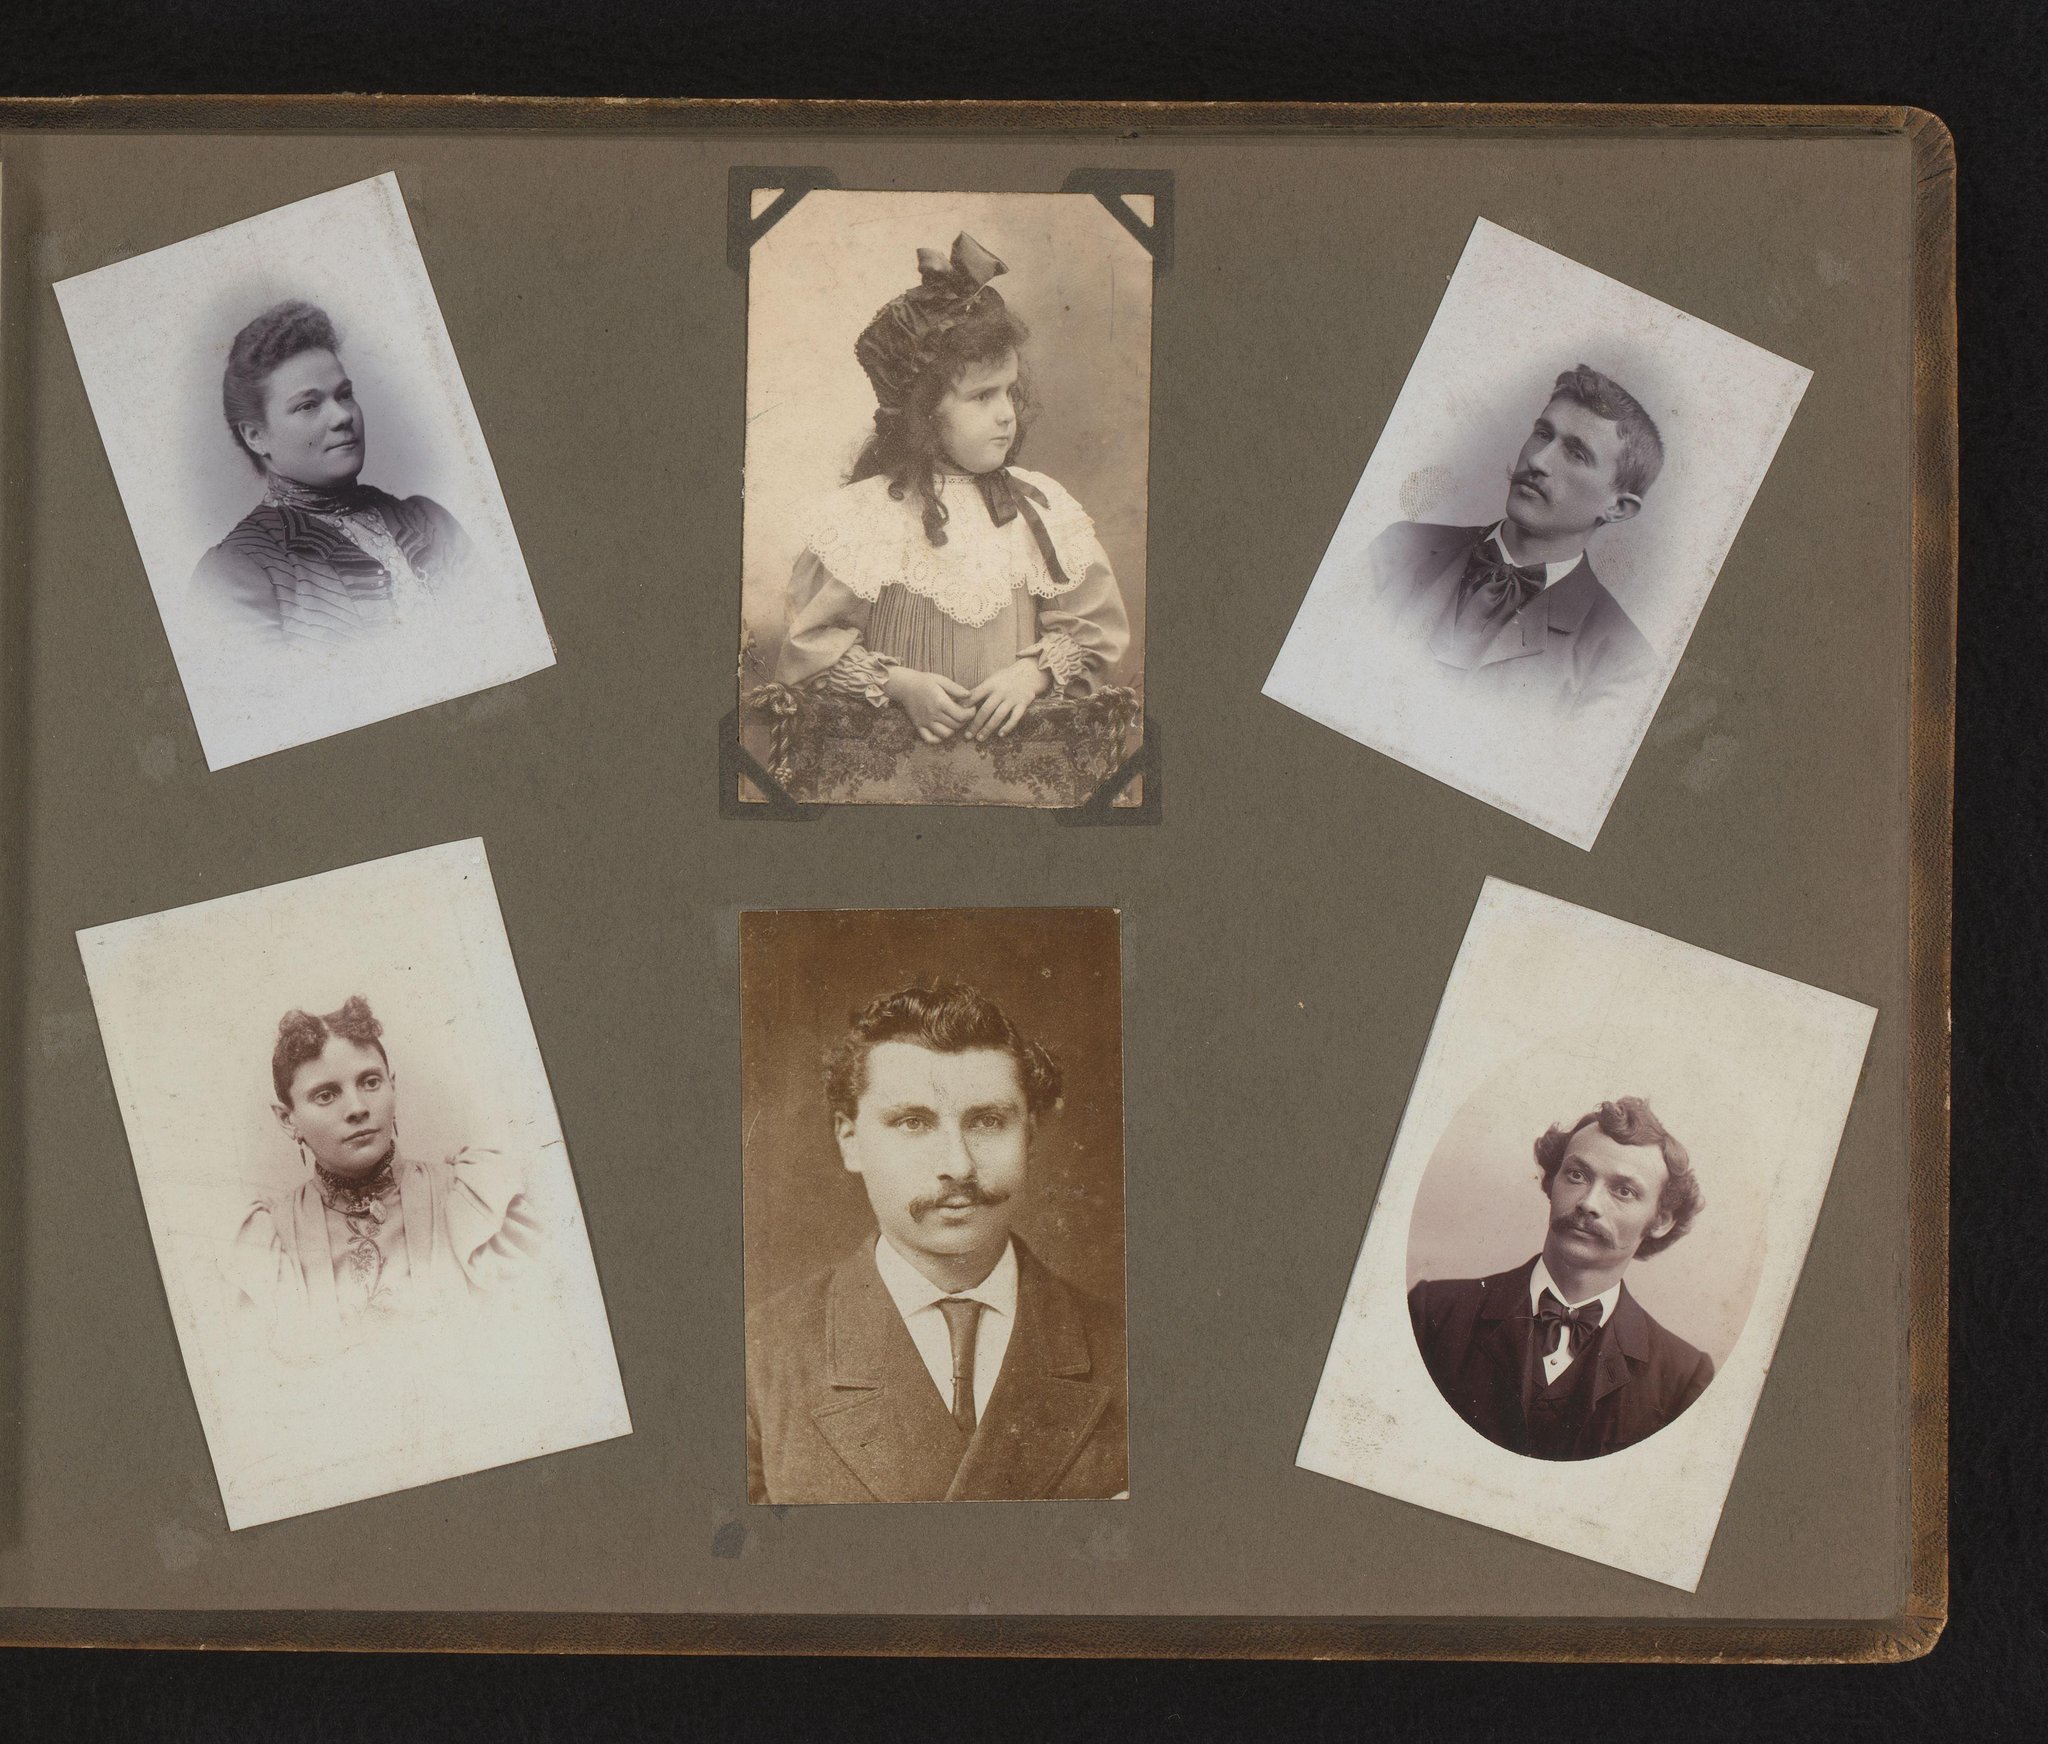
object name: photograph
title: Portretten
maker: Anonymous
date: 1900-1950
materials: photographic support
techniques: collodion silver print, daylight paper print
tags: adult woman, adult man, historical persons, girl (child between toddler and youth)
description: Zes portretten van mannen, vrouwen en een meisje op carte-de-visite formaat. Deze pagina maakt deel uit van een album.